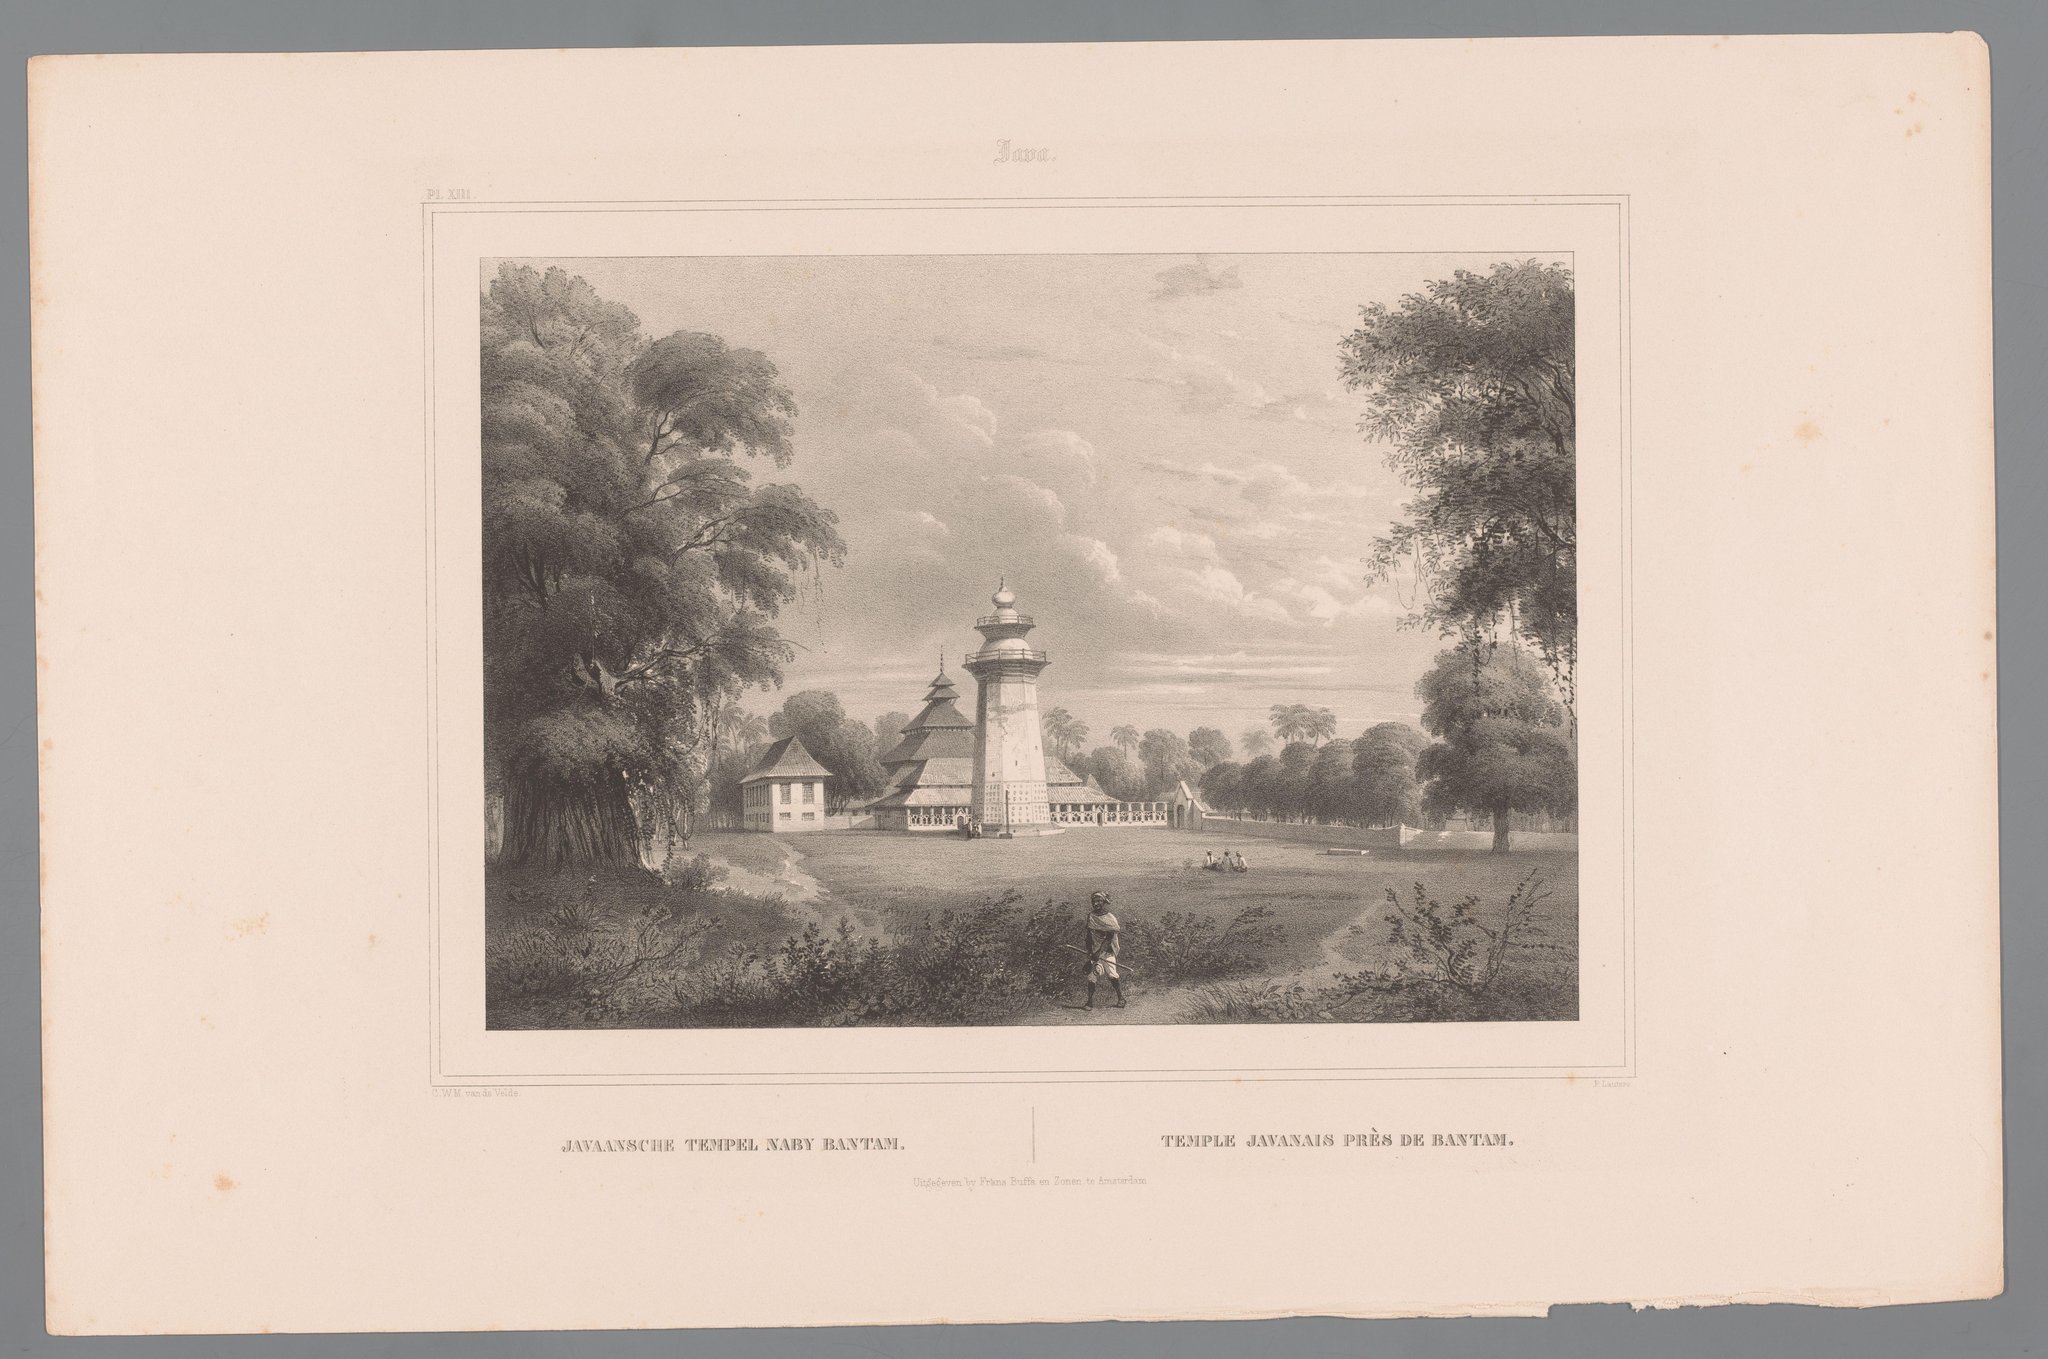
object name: print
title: Gezicht op de moskee bij Bantam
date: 1847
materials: paper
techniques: lithograph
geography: amsterdam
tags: temple, shrine ~ islam, mohammedanism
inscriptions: collector's mark: Lugt 2228